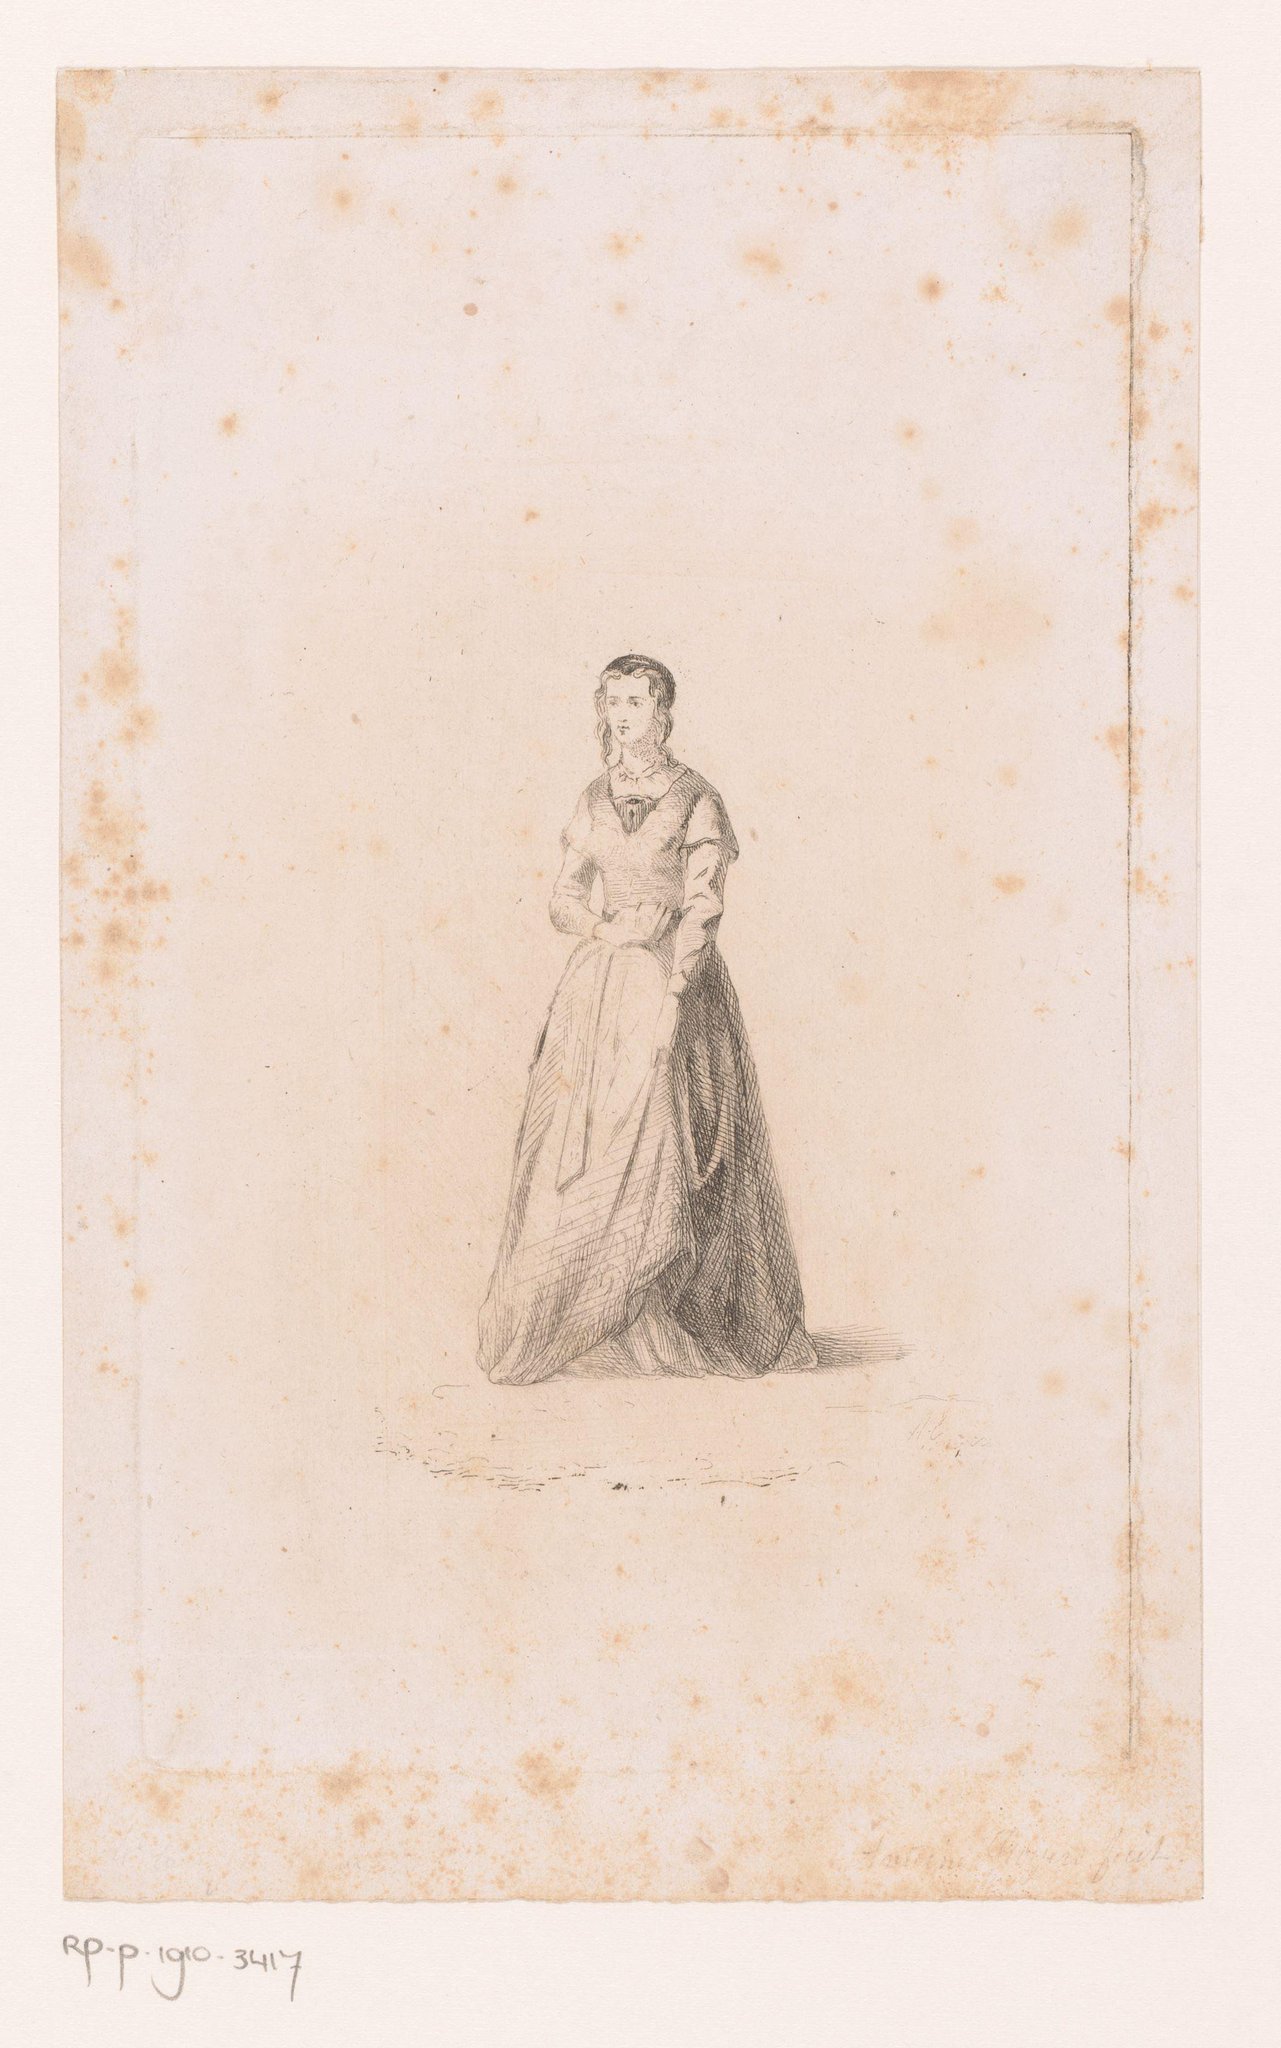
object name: print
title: Staande dame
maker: antonie goyers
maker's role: print maker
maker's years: 1826-1869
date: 1836-1869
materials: paper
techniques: etching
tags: adult woman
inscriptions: collector's mark: Lugt 2228, collector's mark: Lugt 1485